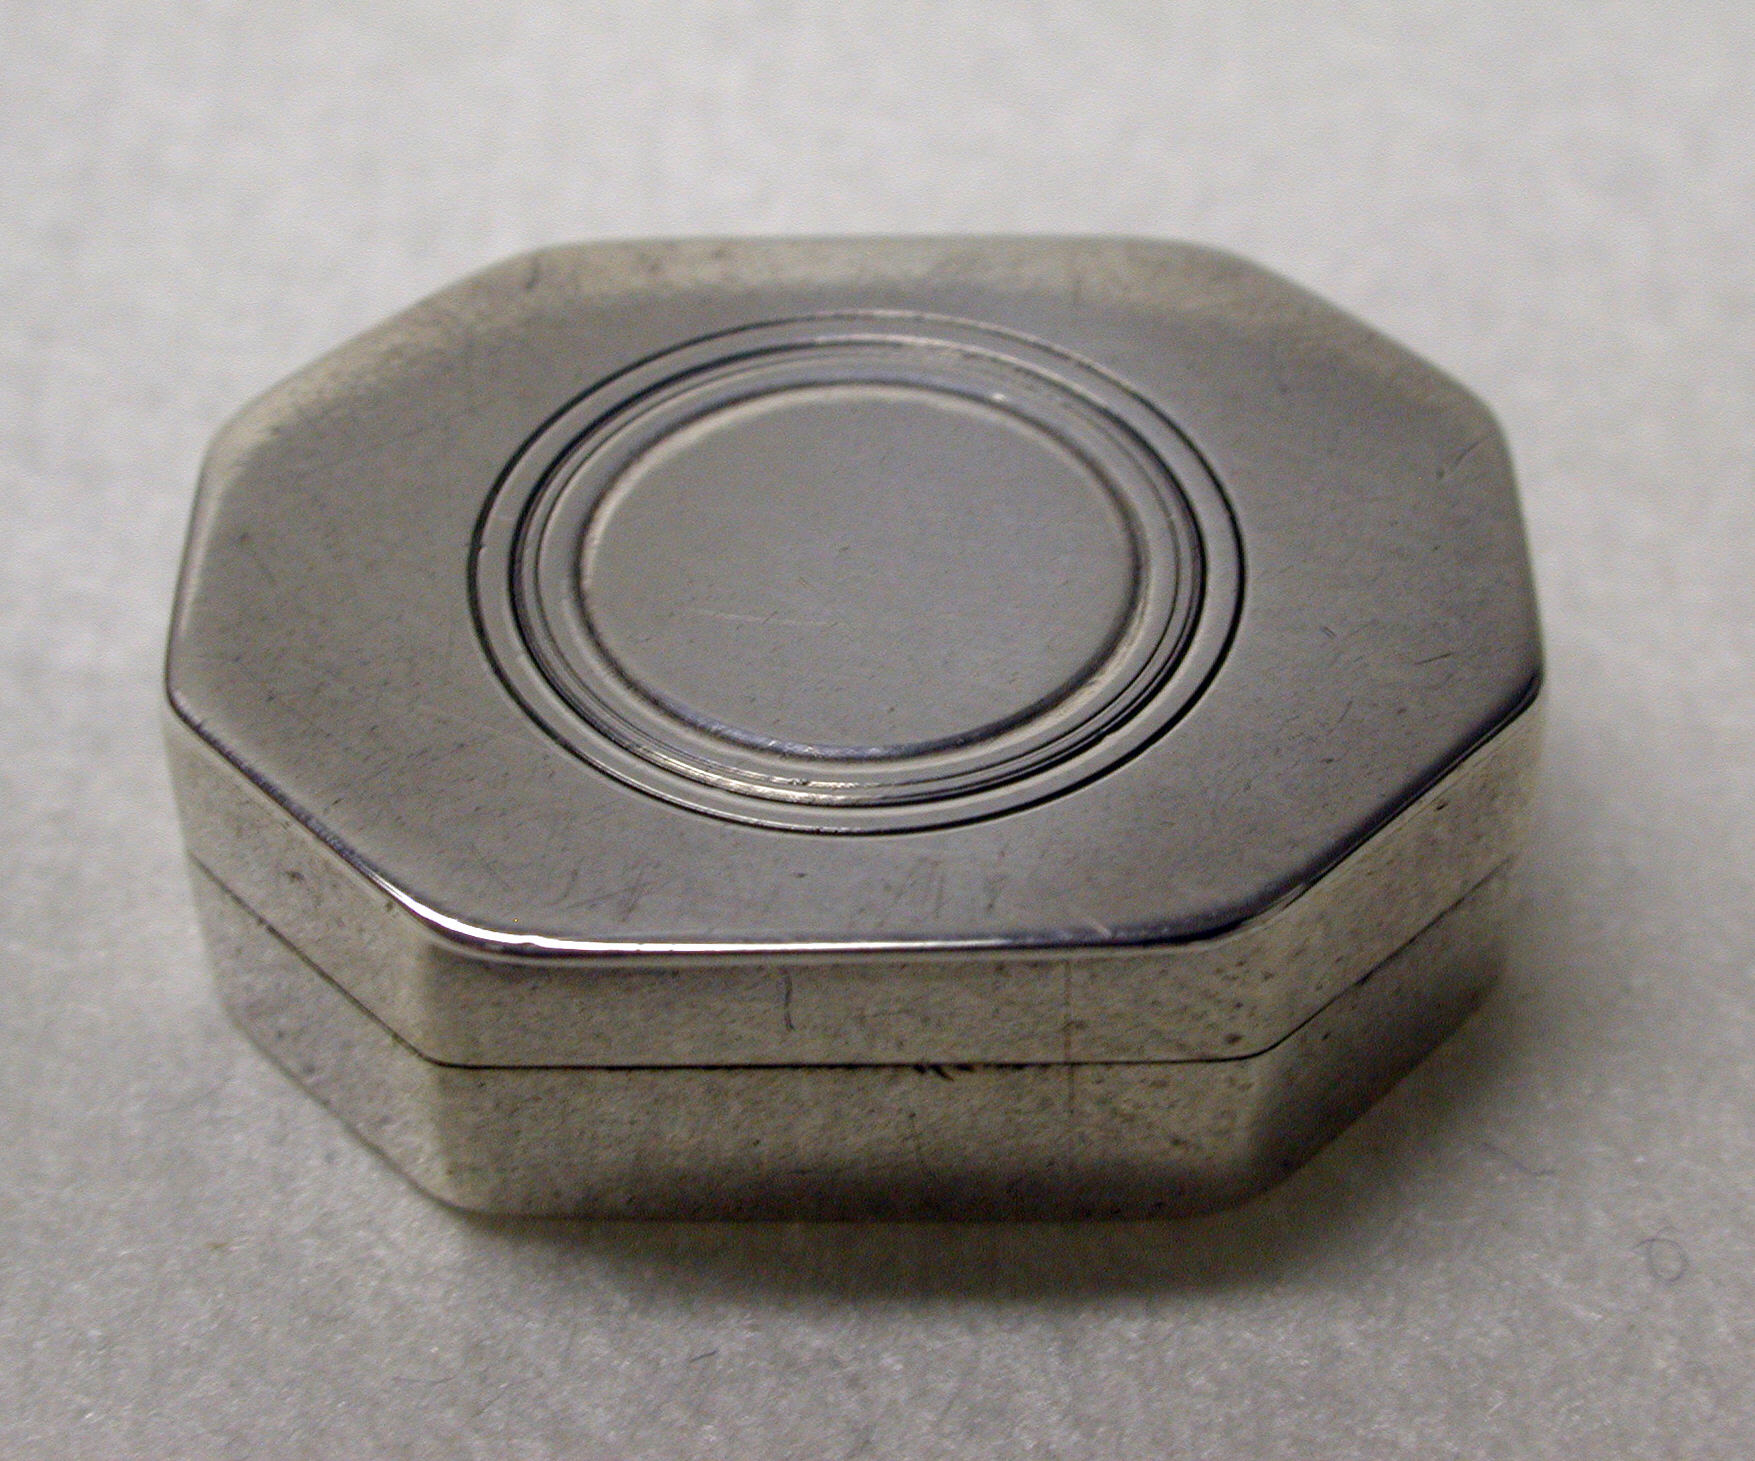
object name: vinaigrette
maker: william thompson ii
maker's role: maker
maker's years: 1802-1818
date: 1803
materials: silver